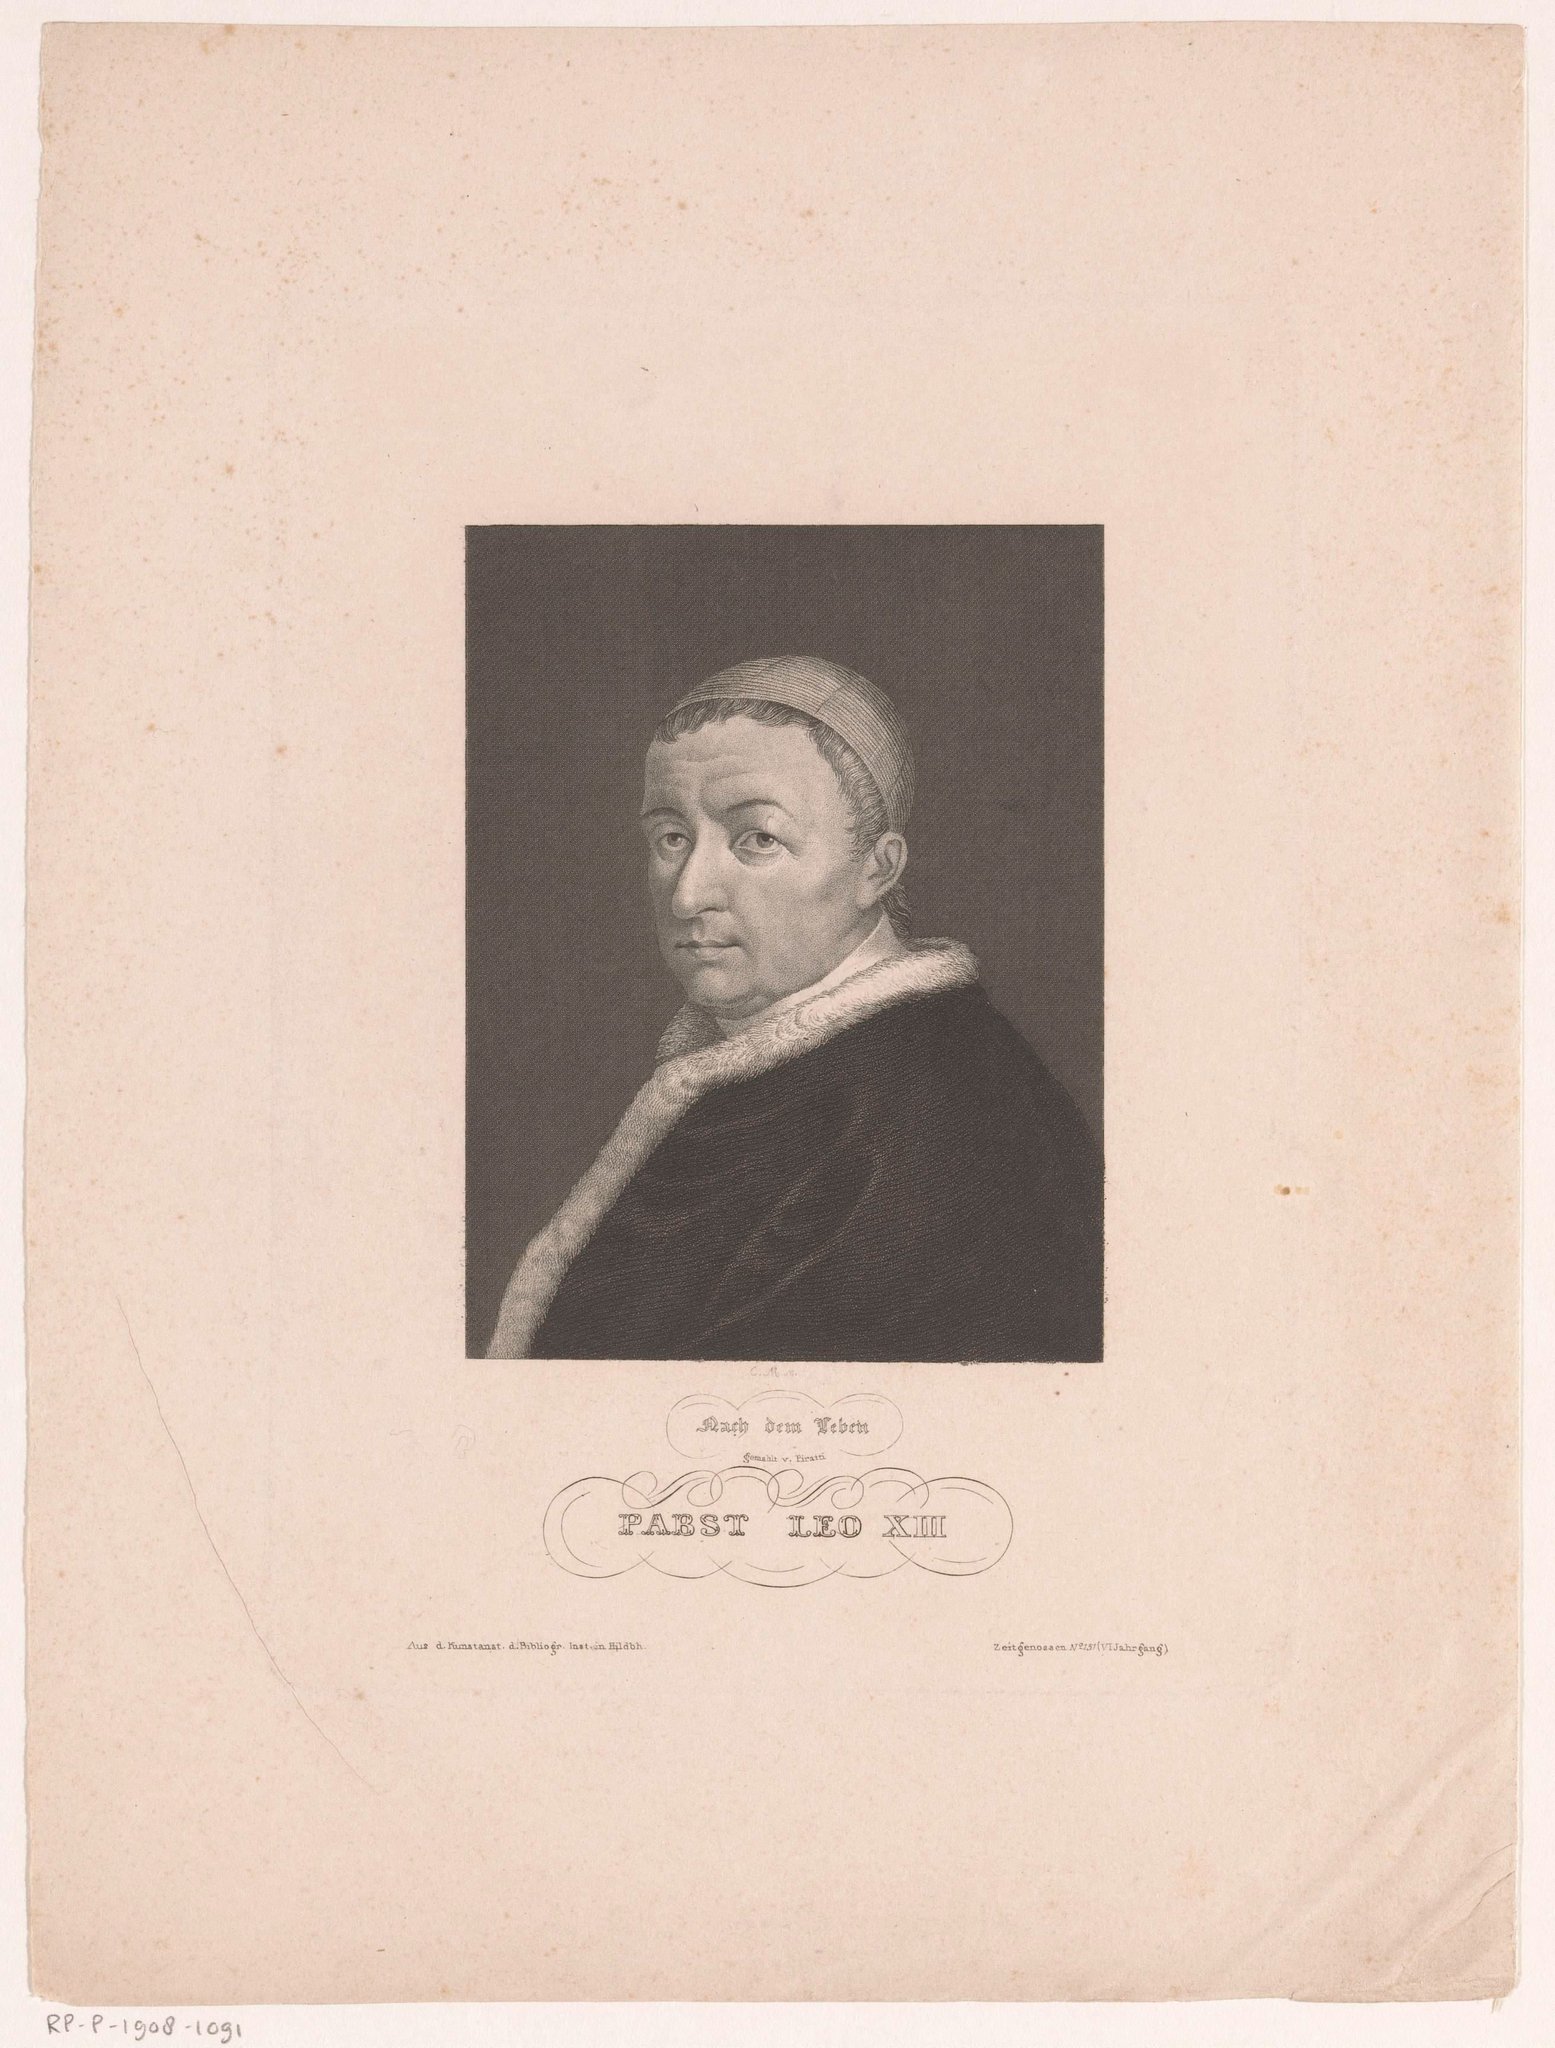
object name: print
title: Zeitgenossen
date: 1829-1840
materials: paper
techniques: engraving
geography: nuremberg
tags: rome, historical persons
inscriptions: collector's mark: Lugt 2228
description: Afkomstig uit de portretserie 'Zeitgenossen', uitgegeven tussen 1829 en circa 1840.